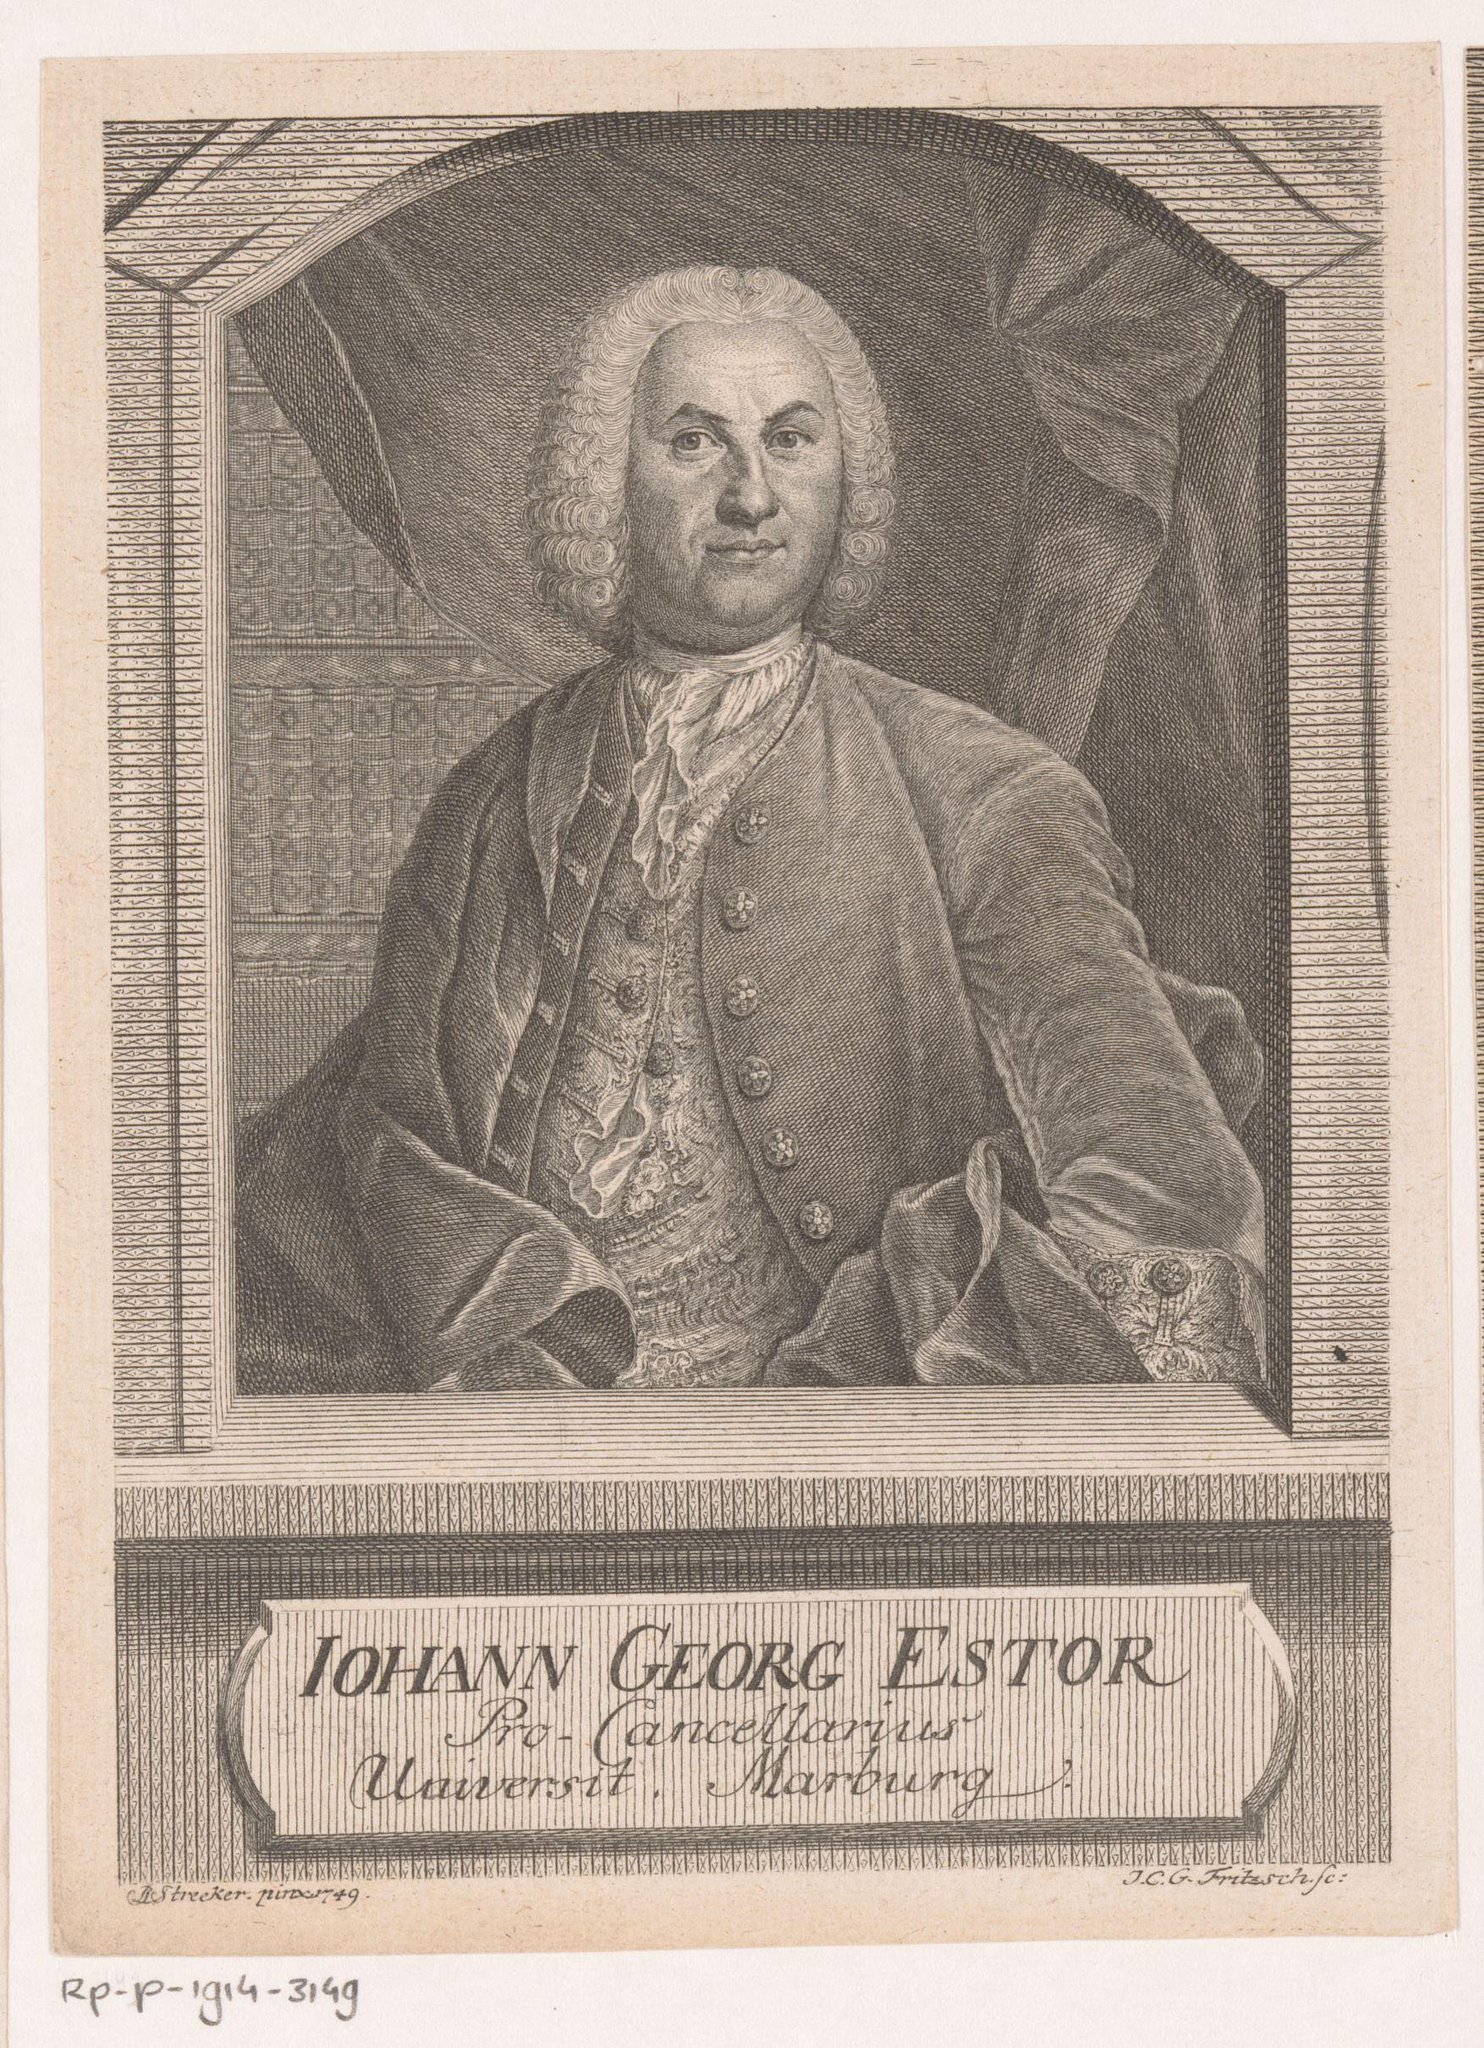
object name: print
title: Portret van Johann Georg Estor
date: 1749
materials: paper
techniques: engraving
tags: bookshelves, historical persons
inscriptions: collector's mark: Lugt 2228